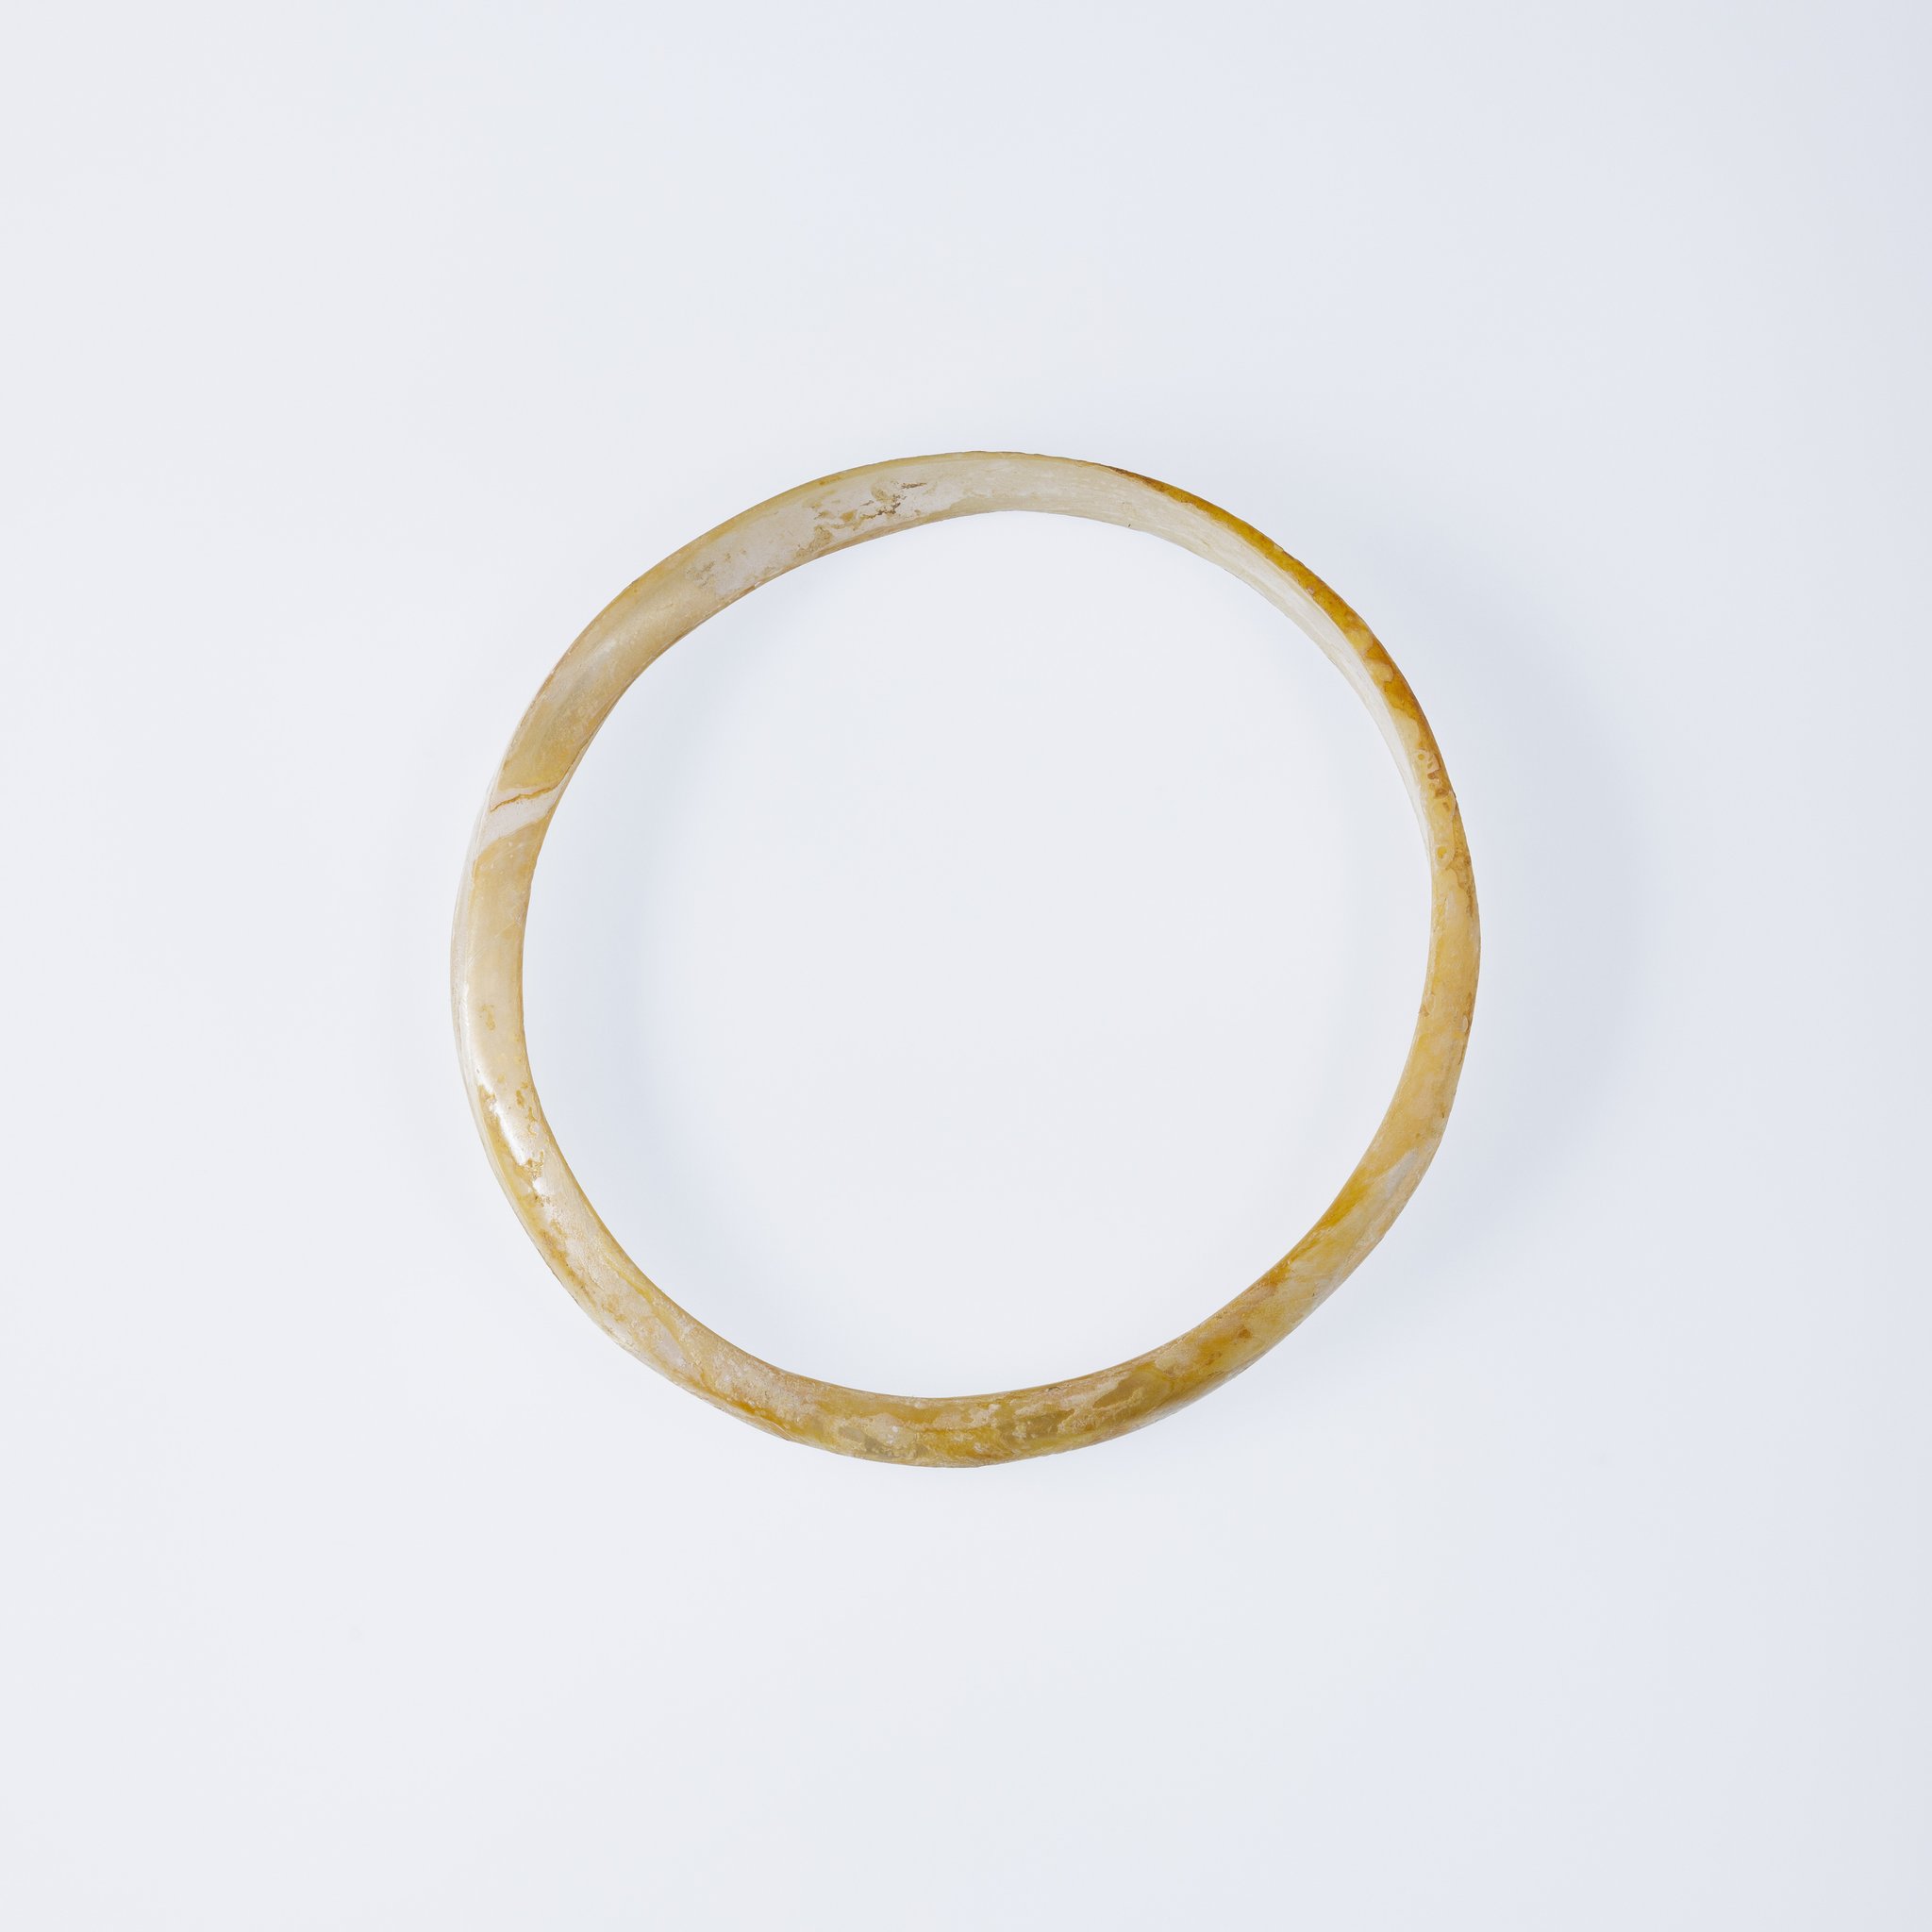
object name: bracelet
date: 2960-2649 BCE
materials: shell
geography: egypt